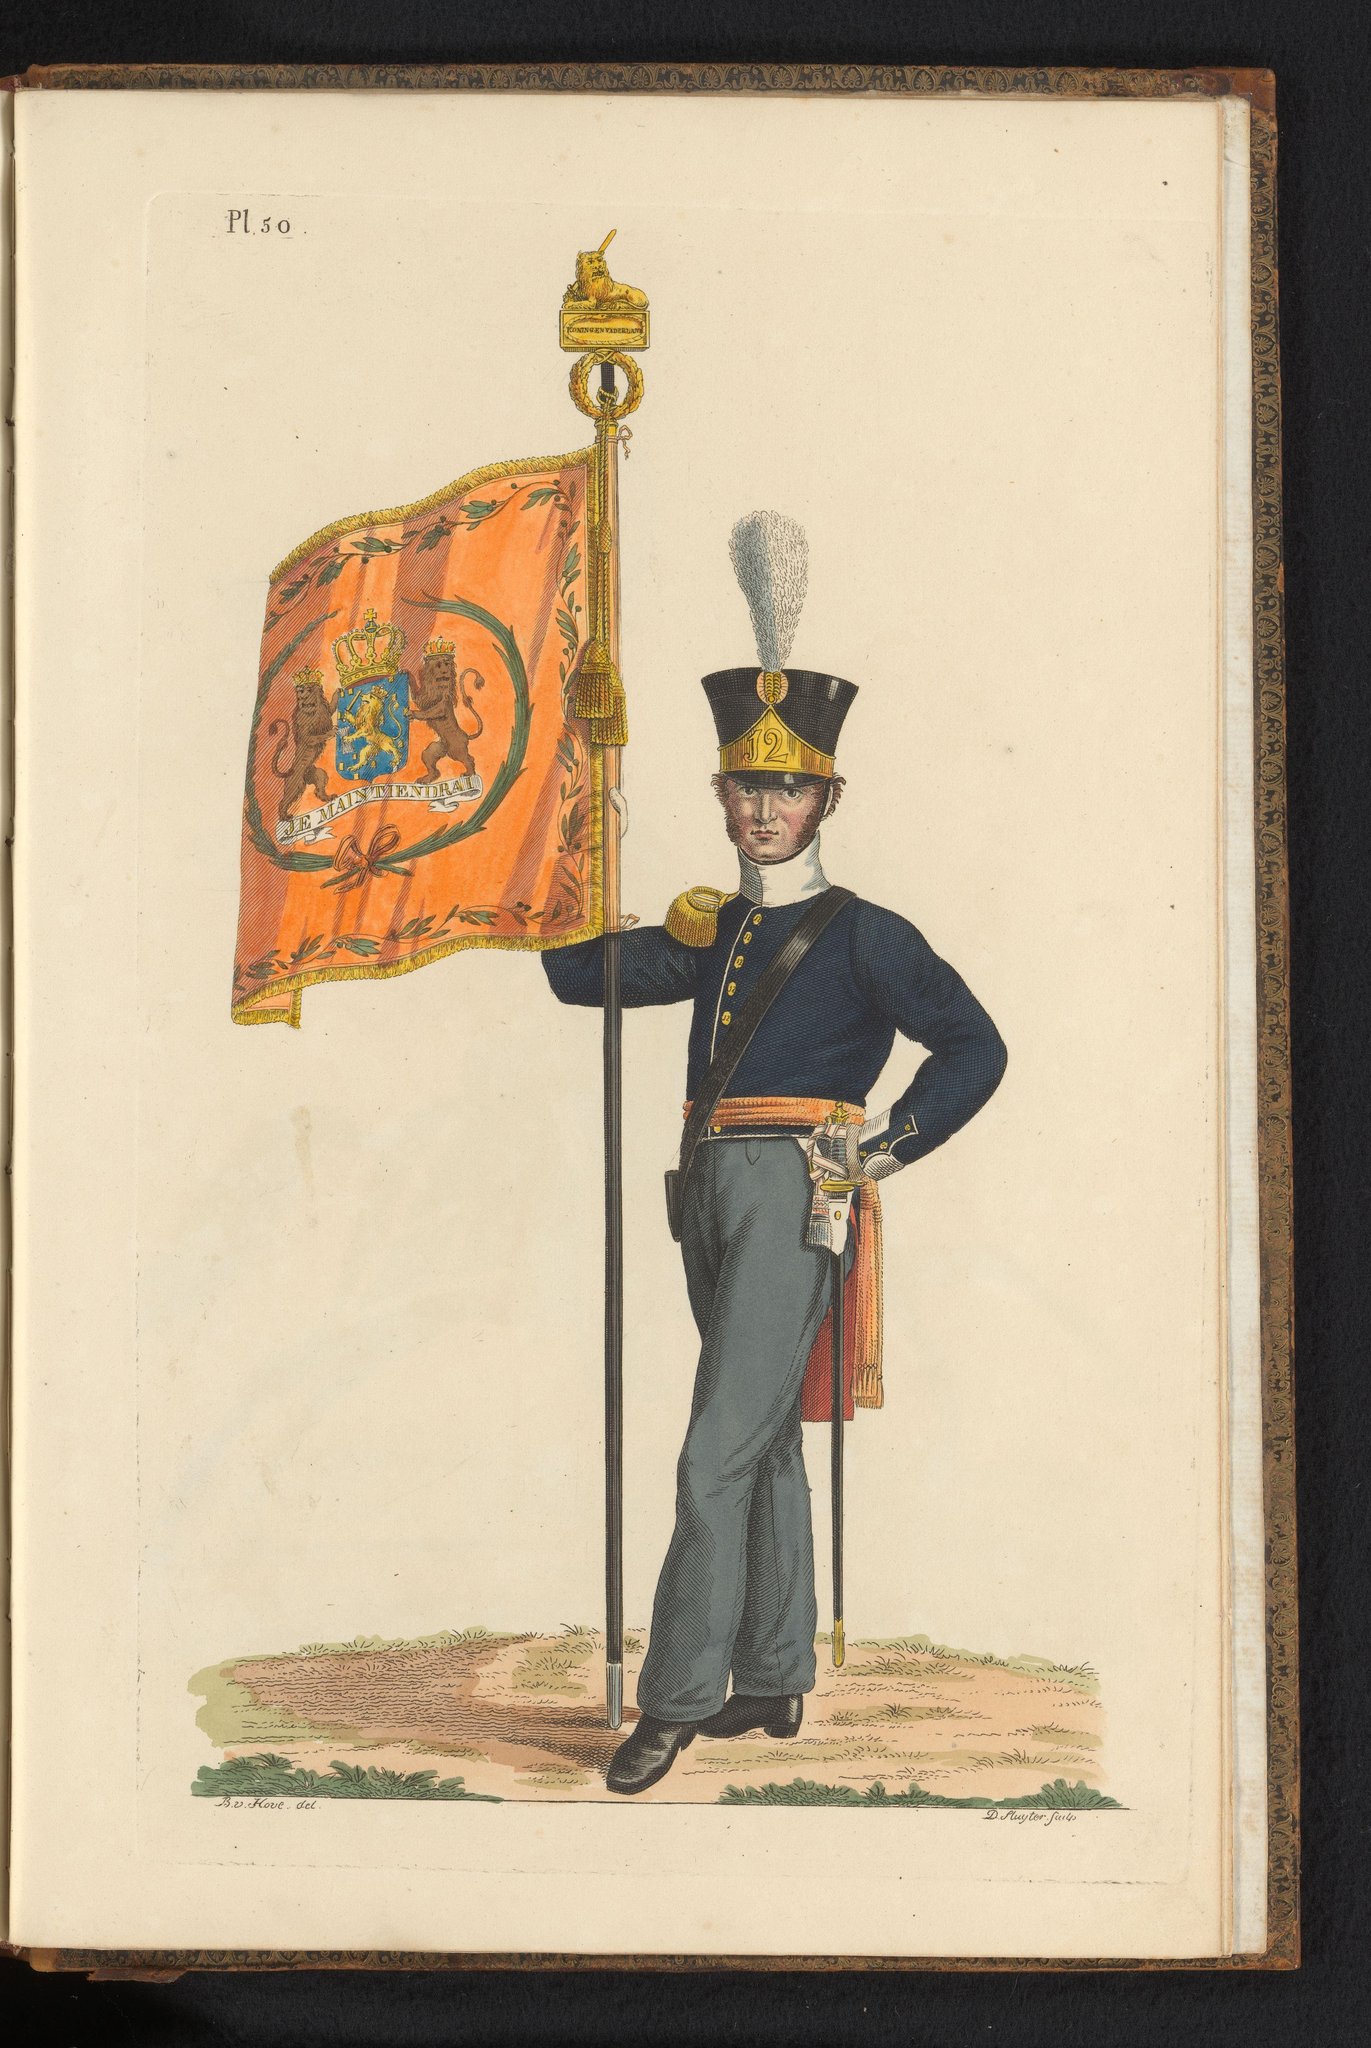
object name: print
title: Vaandrig der Nationale Infanterie, met het Vaandel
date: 1823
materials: paper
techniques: engraving, etching, hand coloring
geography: netherlands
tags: (military) uniforms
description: Een Nederlandse vaandrig van de 12e Afdeling Infanterie. Staande met het vaandel waarop het wapen van het Verenigd Koninkrijk der Nederlanden. Plaat 50. Uniformvoorstelling in 'Beschrijving hoedanig de Koninklijke Nederlandsche troepen' van J.F. Teupken, 1823.